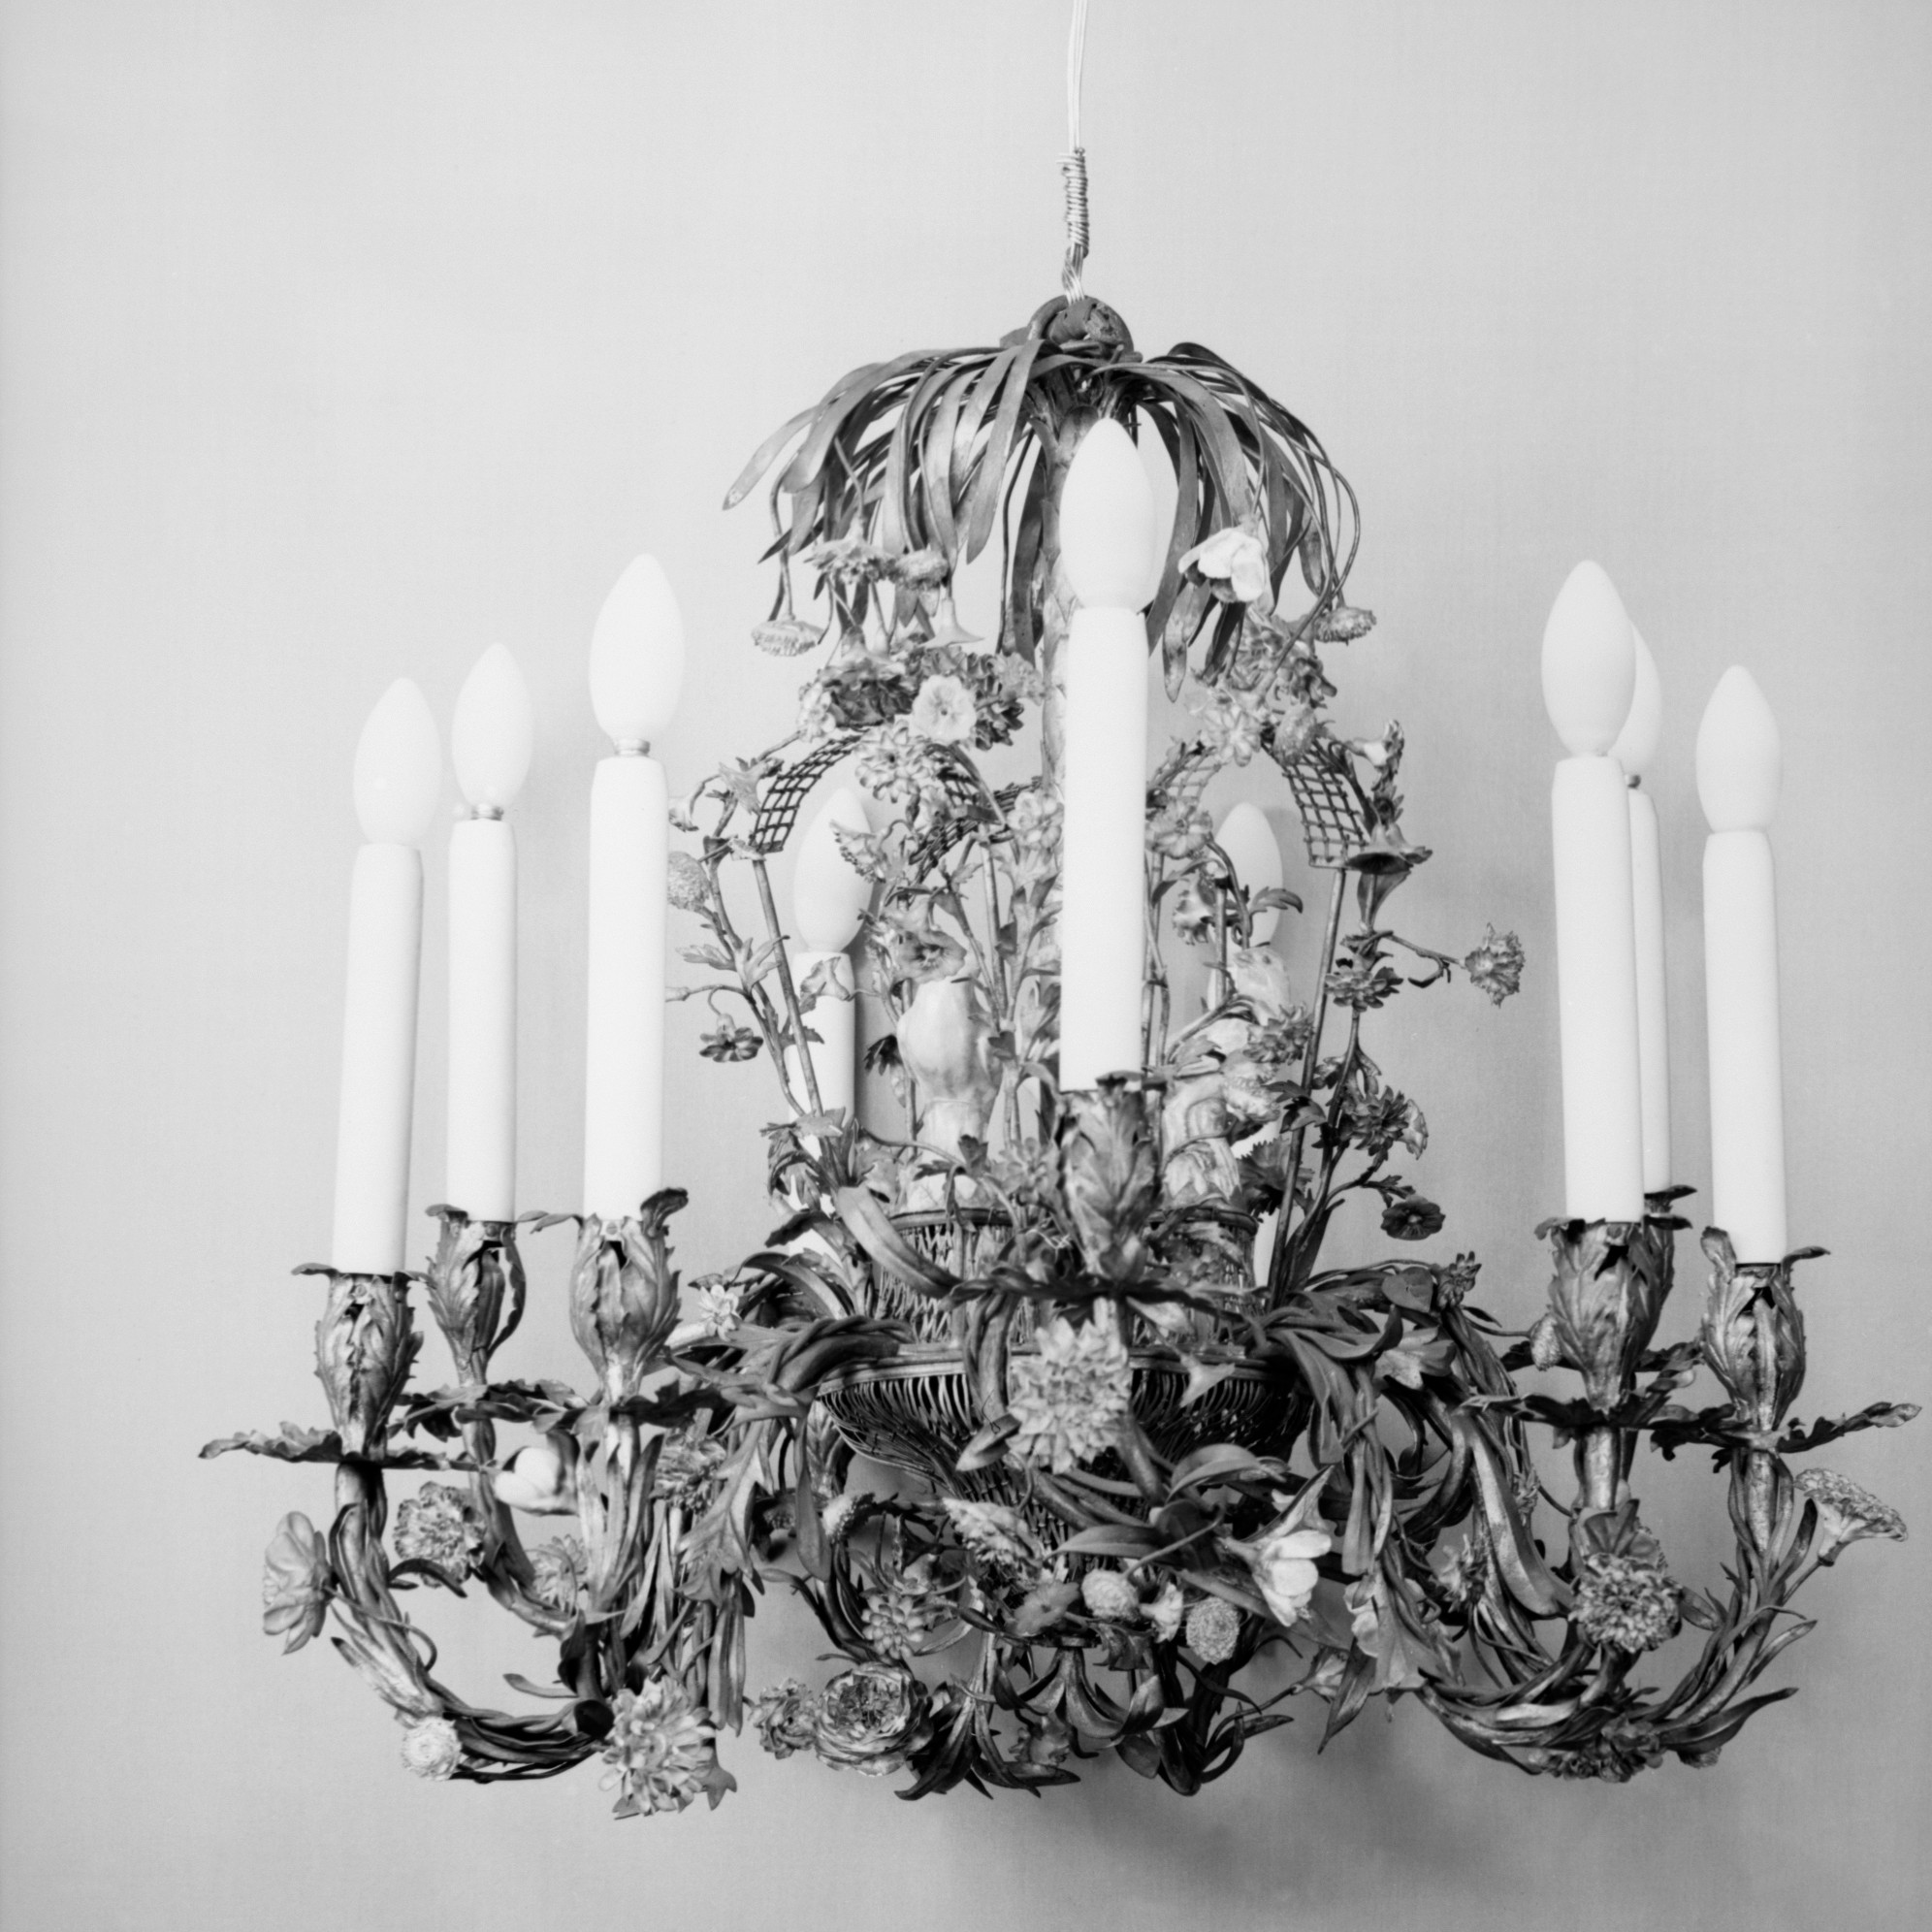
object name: chandelier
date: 1751-1775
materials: brass, gilt, porcelain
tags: flowers